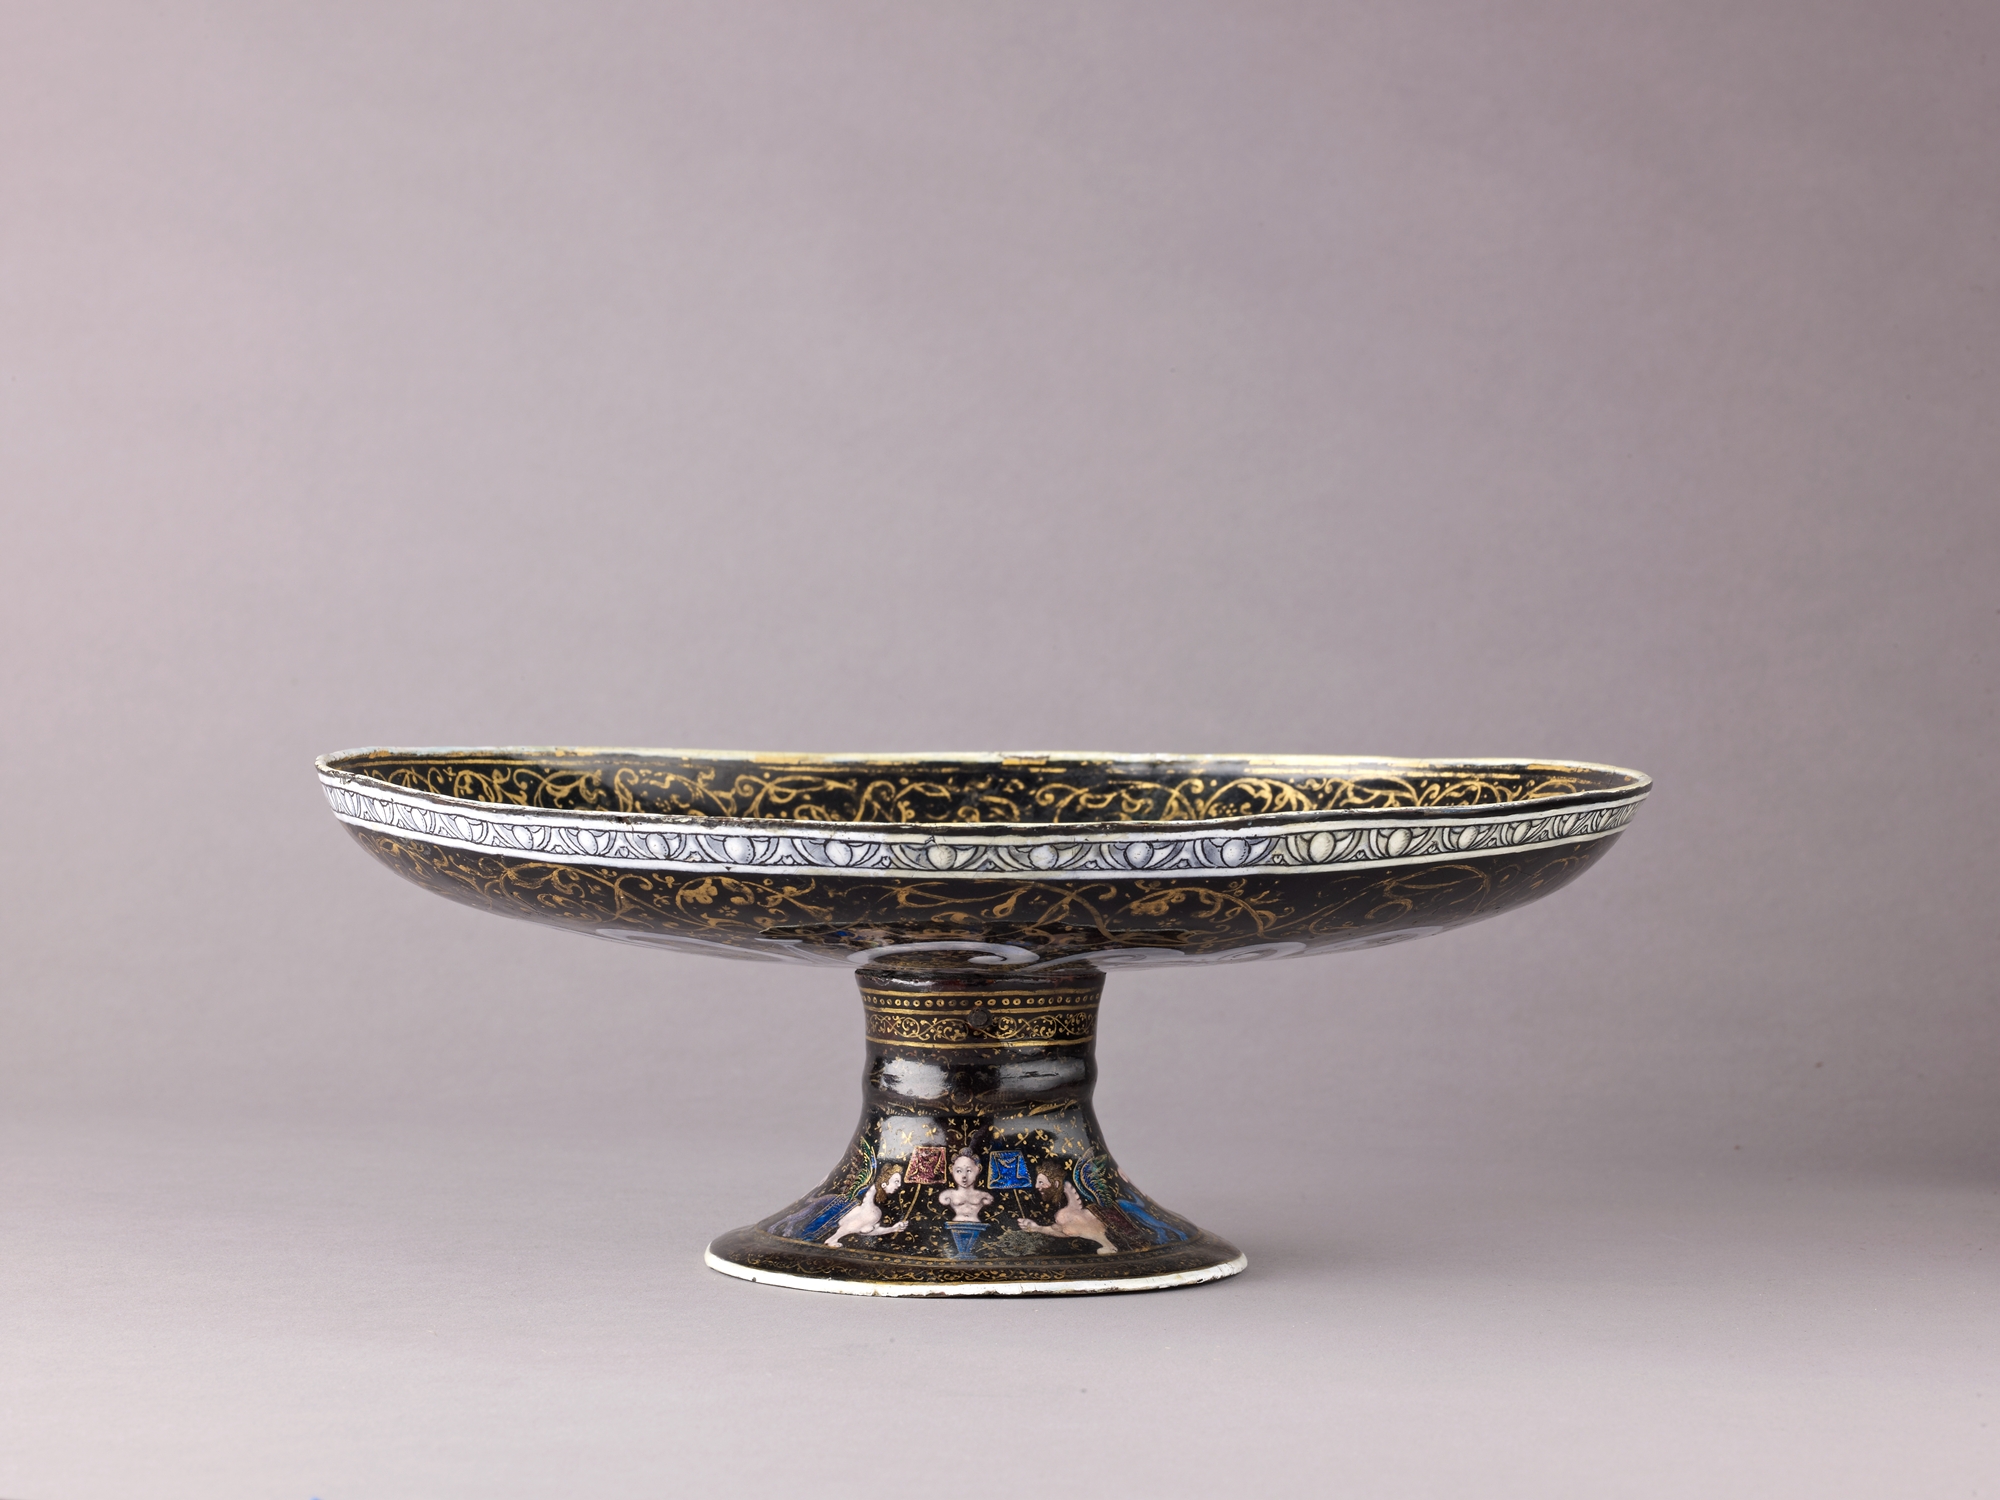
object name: tazza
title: Christ and the Woman of Samaria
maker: suzanne de court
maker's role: artist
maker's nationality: french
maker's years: 1575-1625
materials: copper, enamel, gilt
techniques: painting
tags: men,women,christ